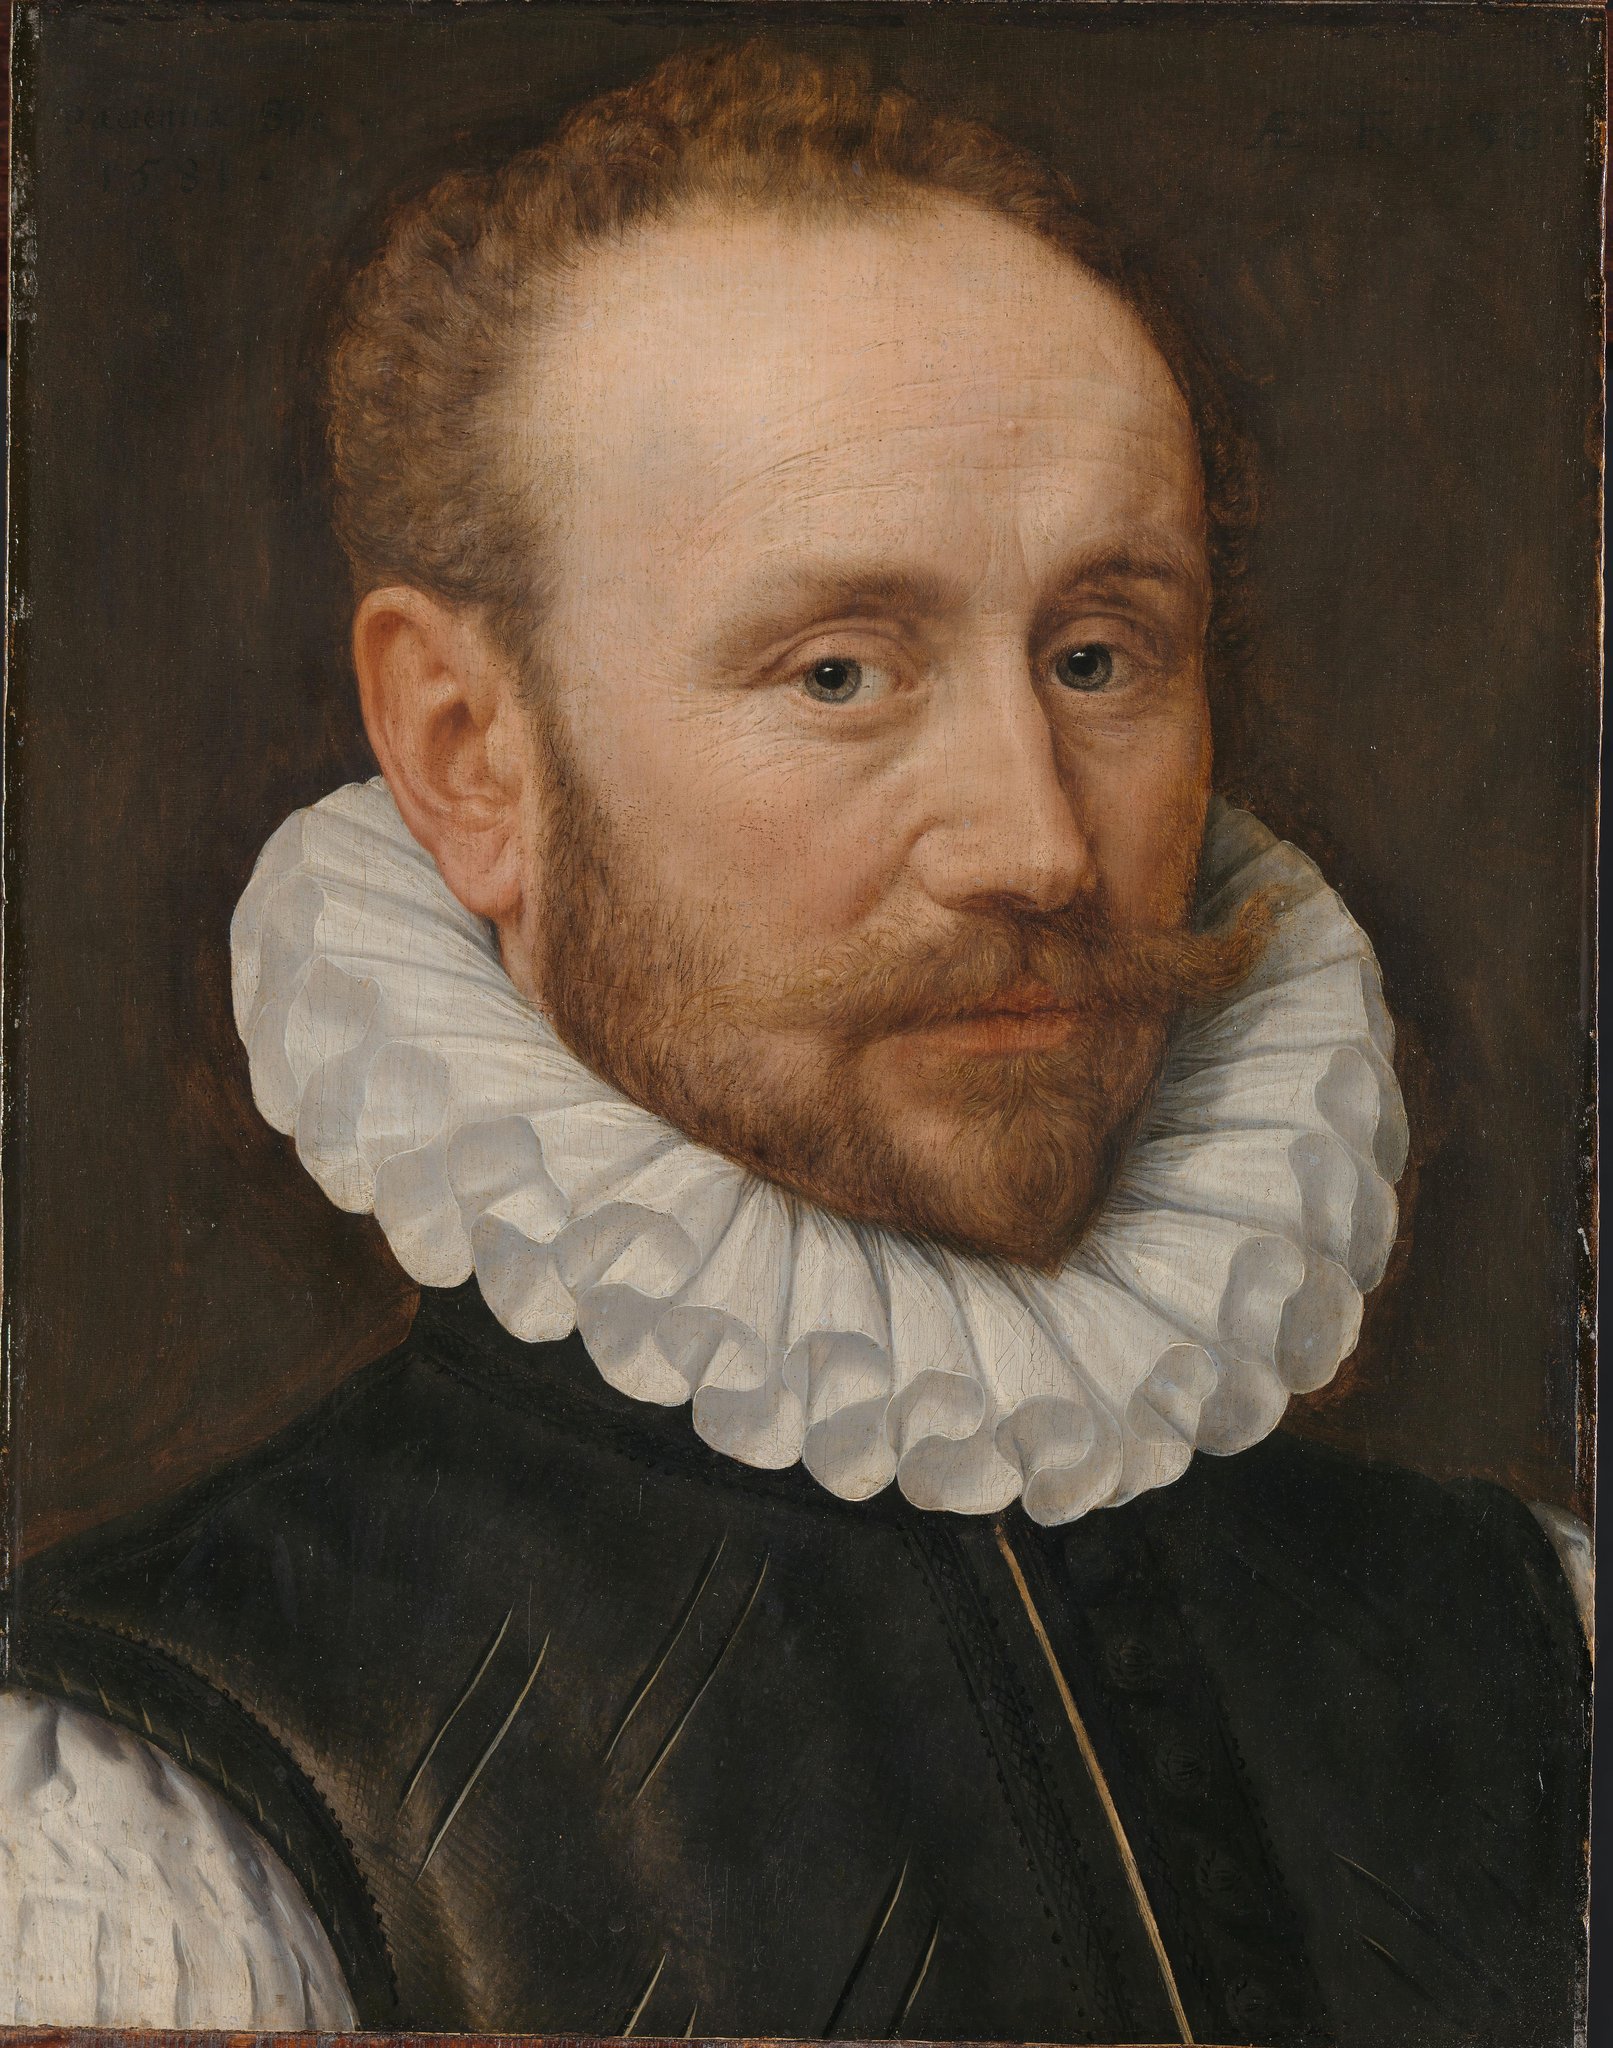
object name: painting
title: Portrait of a Man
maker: adriaen thomasz. key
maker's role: painter, print maker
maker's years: 1544-1589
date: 1581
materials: oil, panel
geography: antwerp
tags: neck-gear: collar, historical persons not known by name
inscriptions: signature, date and inscription, upper left: ‘ATK 1581. AE 38 Pacientia Spe’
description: Unfortunately, the identity of this man wearing a ruff and slashed doublet is not known. The inscription at upper left reveals that he was 38 years old in 1581, when this portrait was painted. To judge from his Latin motto Patientia Spe (‘With patience and hope’), he must have been a cautious man – a trait that is certainly conveyed here.